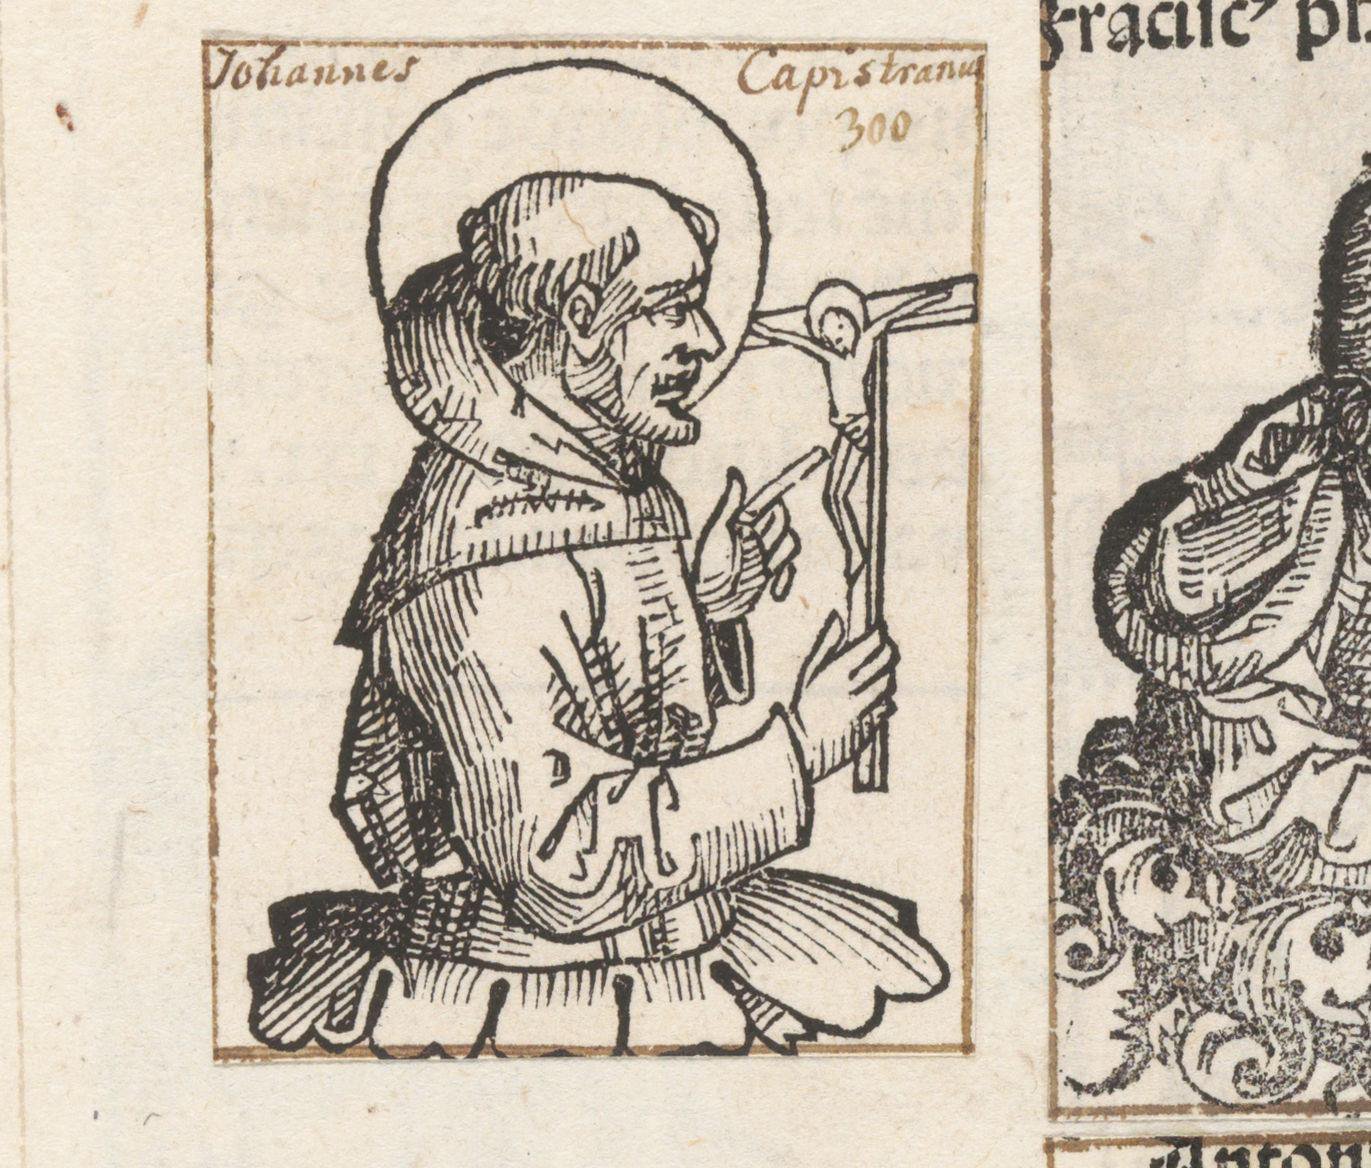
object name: book illustration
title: Johannes van Capestrano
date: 1493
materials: paper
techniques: letterpress printing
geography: nuremberg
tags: the franciscan friar john of capestrano; possible attributes: (monstrance with) ihs-monogram, banner with red cross, crucifix, turk under feet, monk(s), friar(s)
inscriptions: inscription: ‘Johannes Capistrano / 300’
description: De houtsnede wordt herhaaldelijk gebruikt als boekillustratie in de Liber Chronicarum (of Neurenbergkroniek) van Hartmann Schedel, verschenen in het Latijn en Duits in 1493. Zie de Latijnse uitgave, folio 249v.